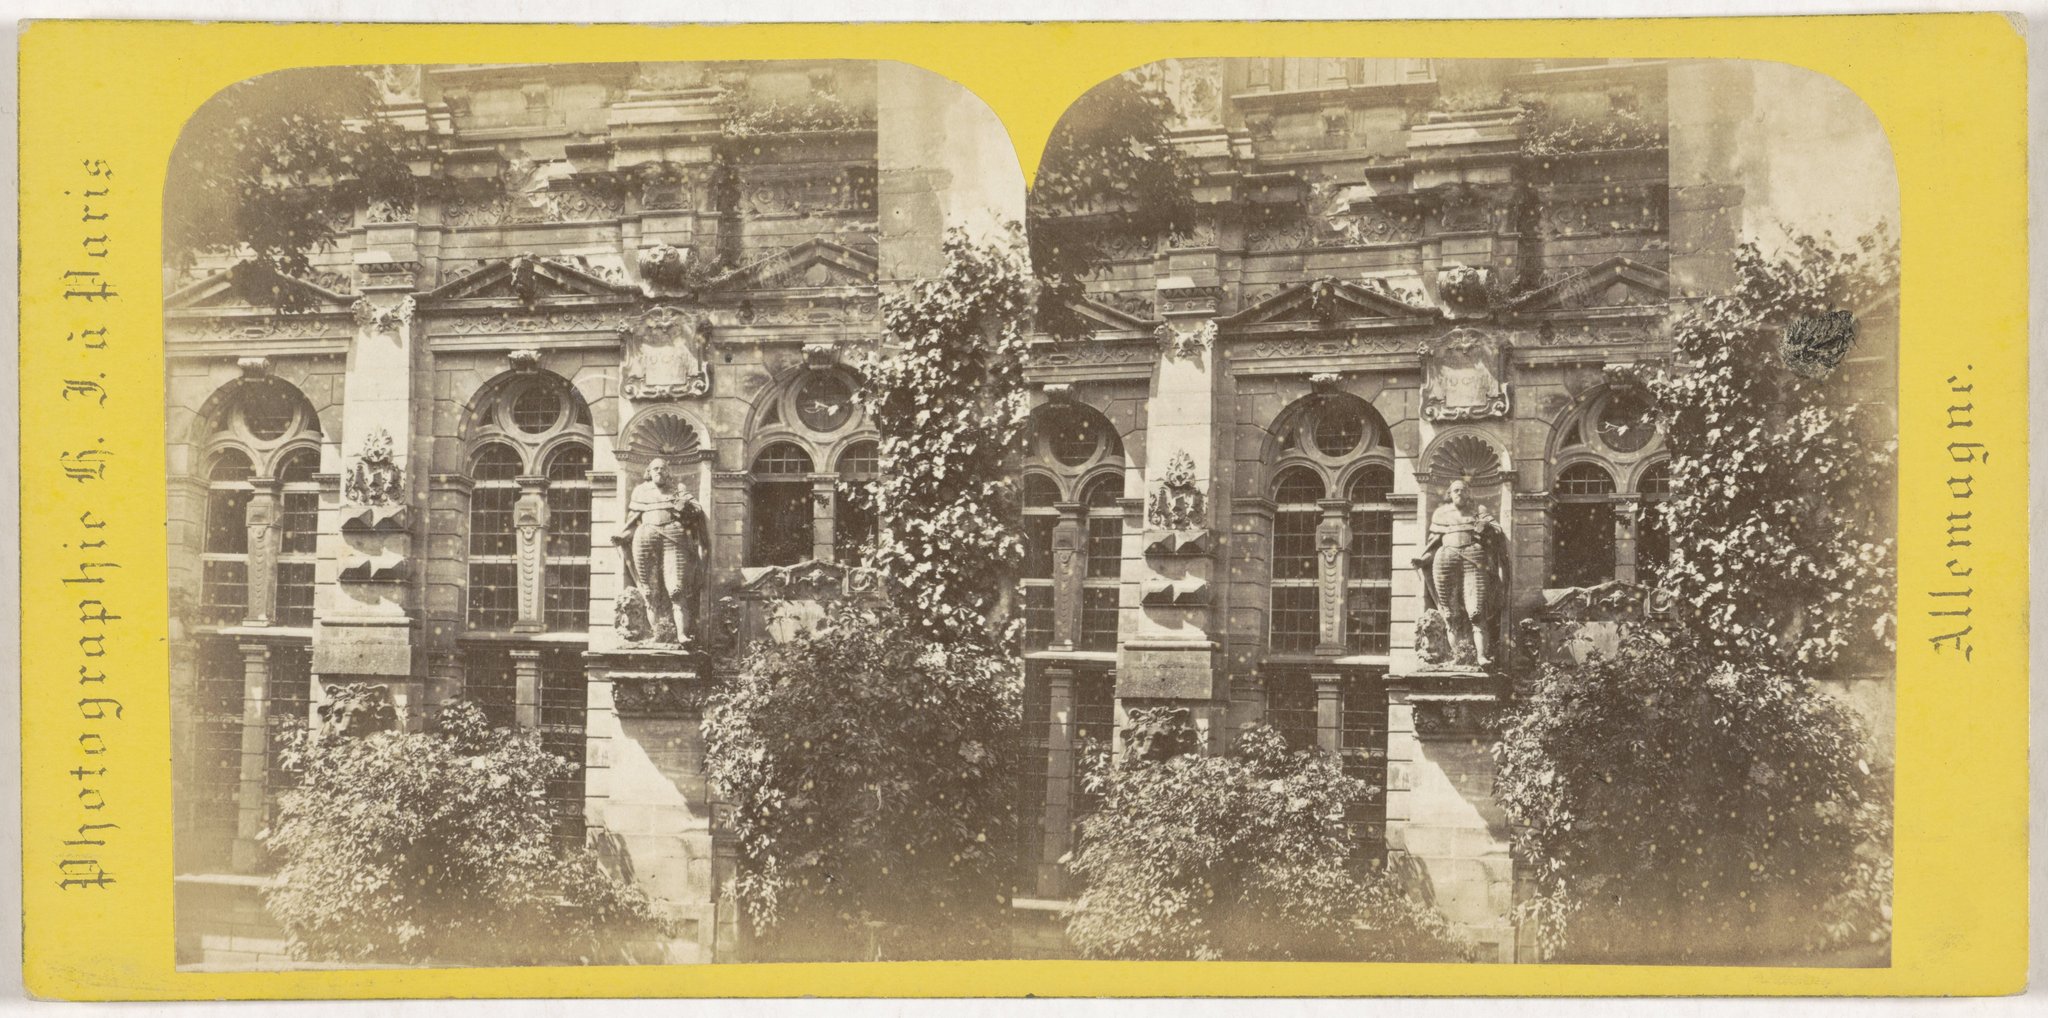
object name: stereograph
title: Heidelberg (Grand-Duché de Bade), details palais Frederic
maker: hippolyte jouvin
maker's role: fotograaf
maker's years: 1825-1889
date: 1860-1865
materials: cardboard, paper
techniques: albumen print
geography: heidelberg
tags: sculpture, façade (of house or building)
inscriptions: number: ‘N. 355’, copyright notice: ‘Déposé.’